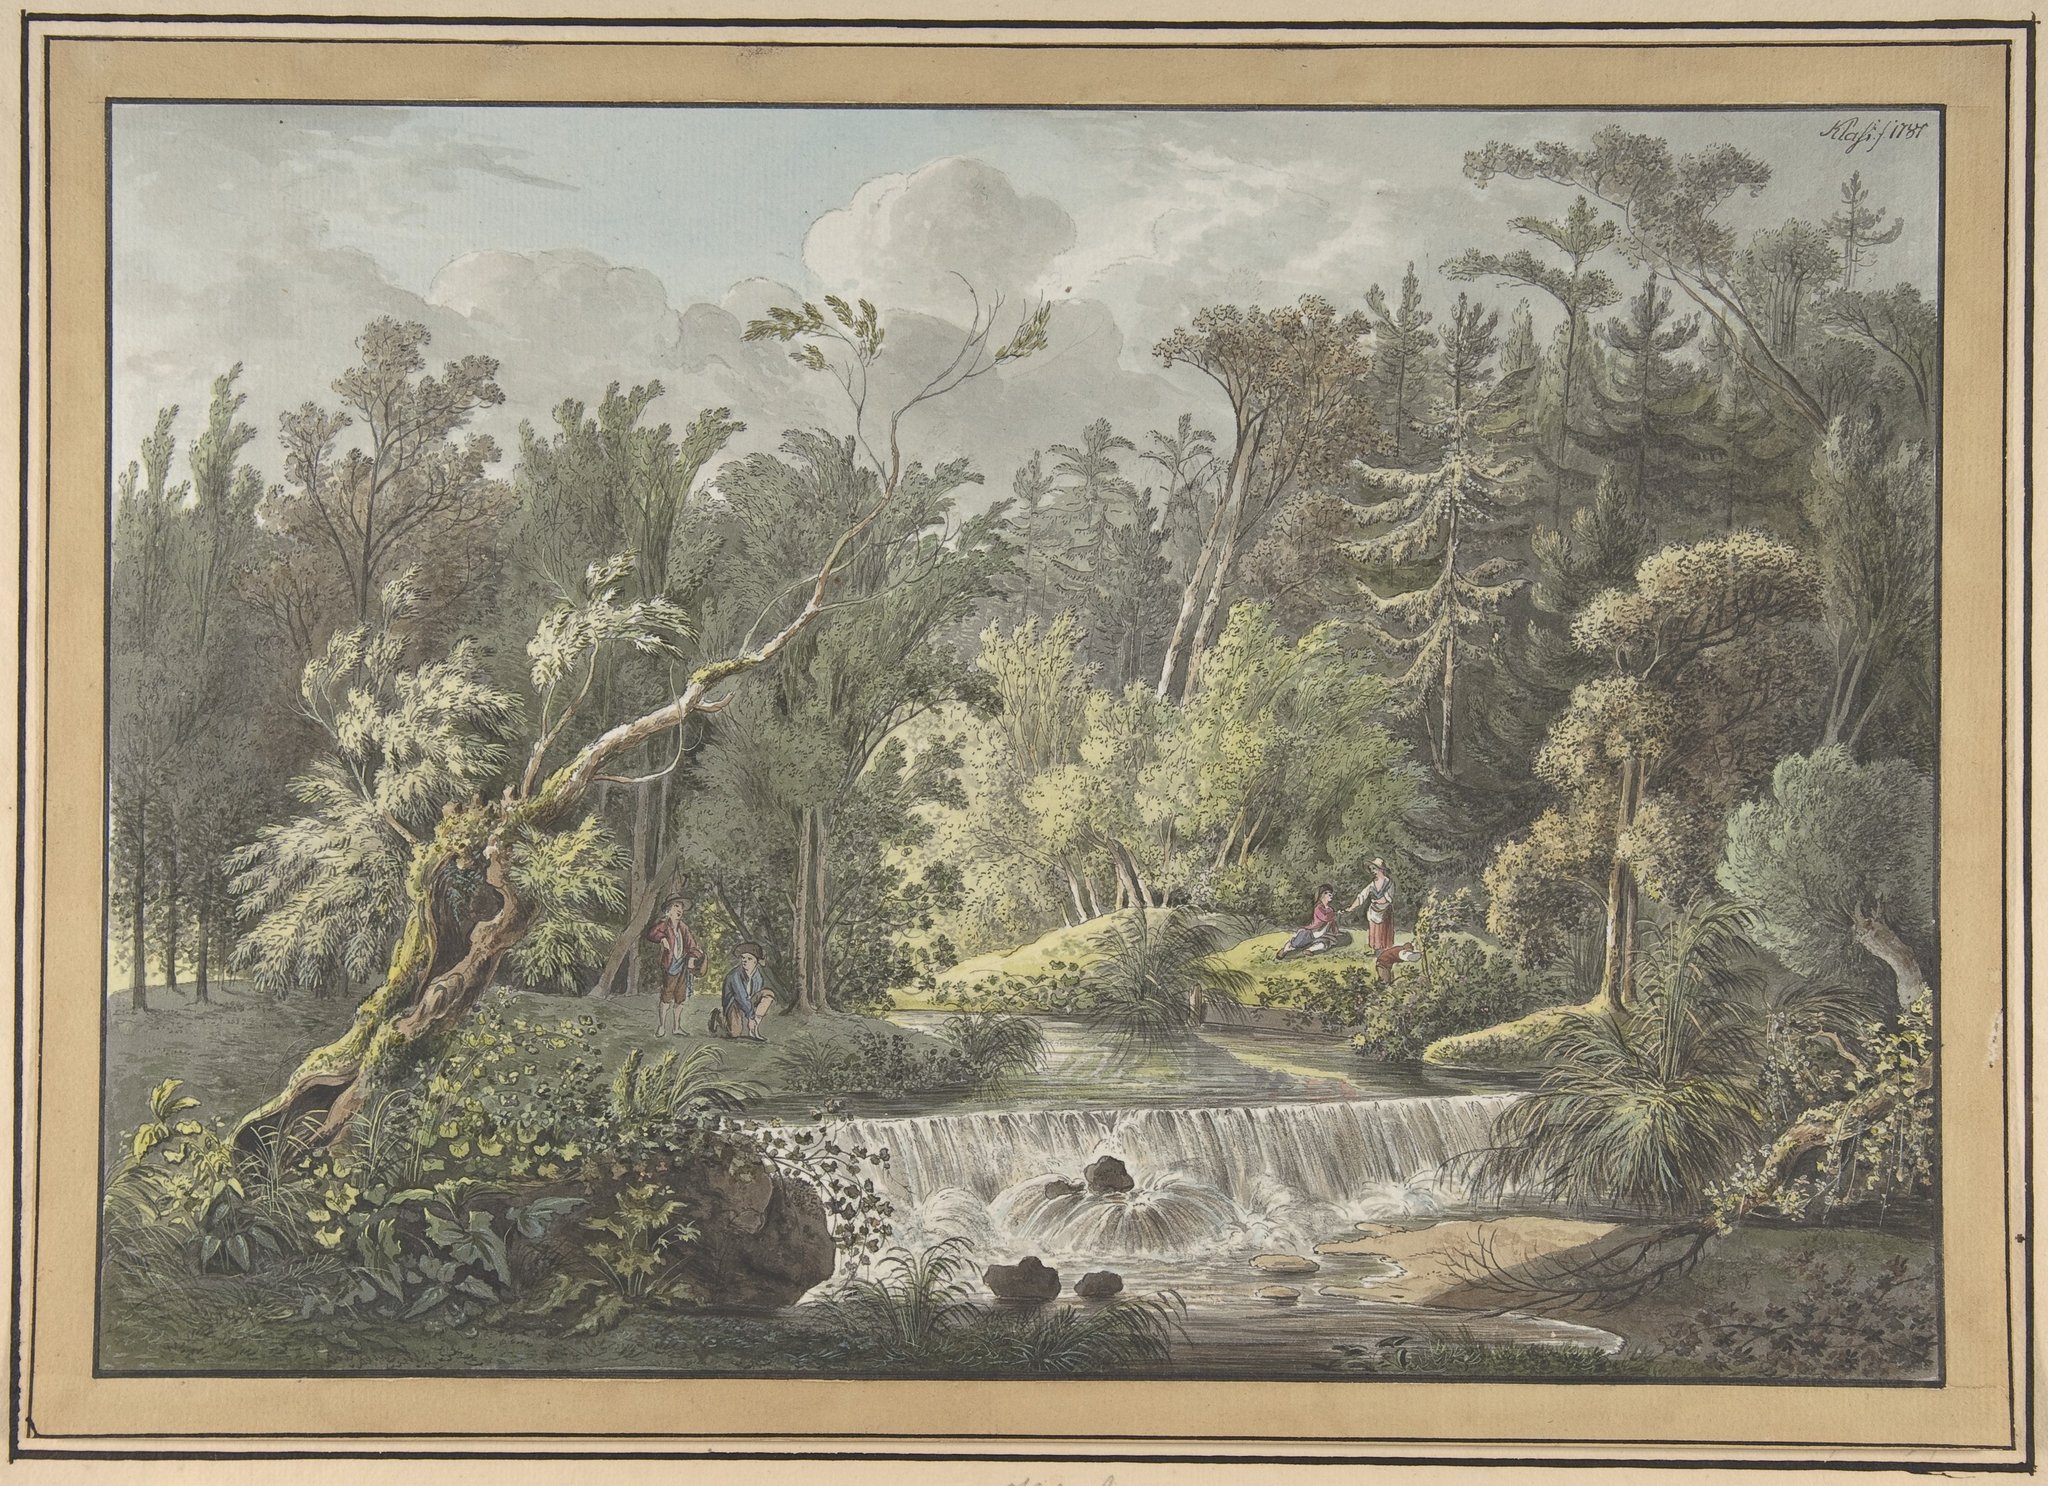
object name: drawing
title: Landscape with Waterfall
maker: friedrich christian klass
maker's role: artist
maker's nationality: german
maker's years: 1752-1827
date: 1767-1833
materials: ink, watercolor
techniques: pen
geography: germany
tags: waterfalls,landscapes,trees